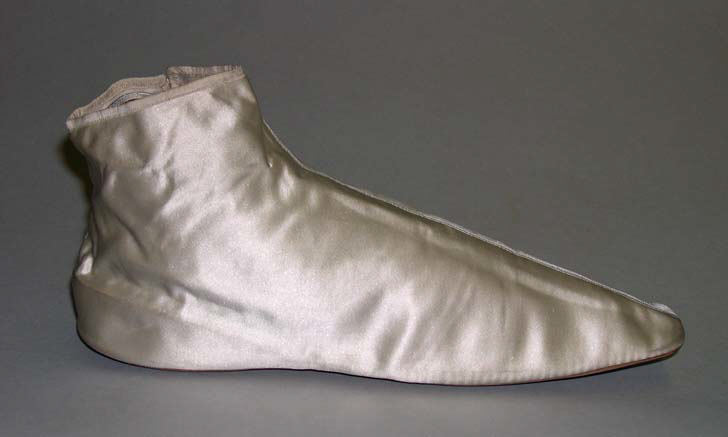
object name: wedding slipper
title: Wedding slippers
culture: american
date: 1856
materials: leather